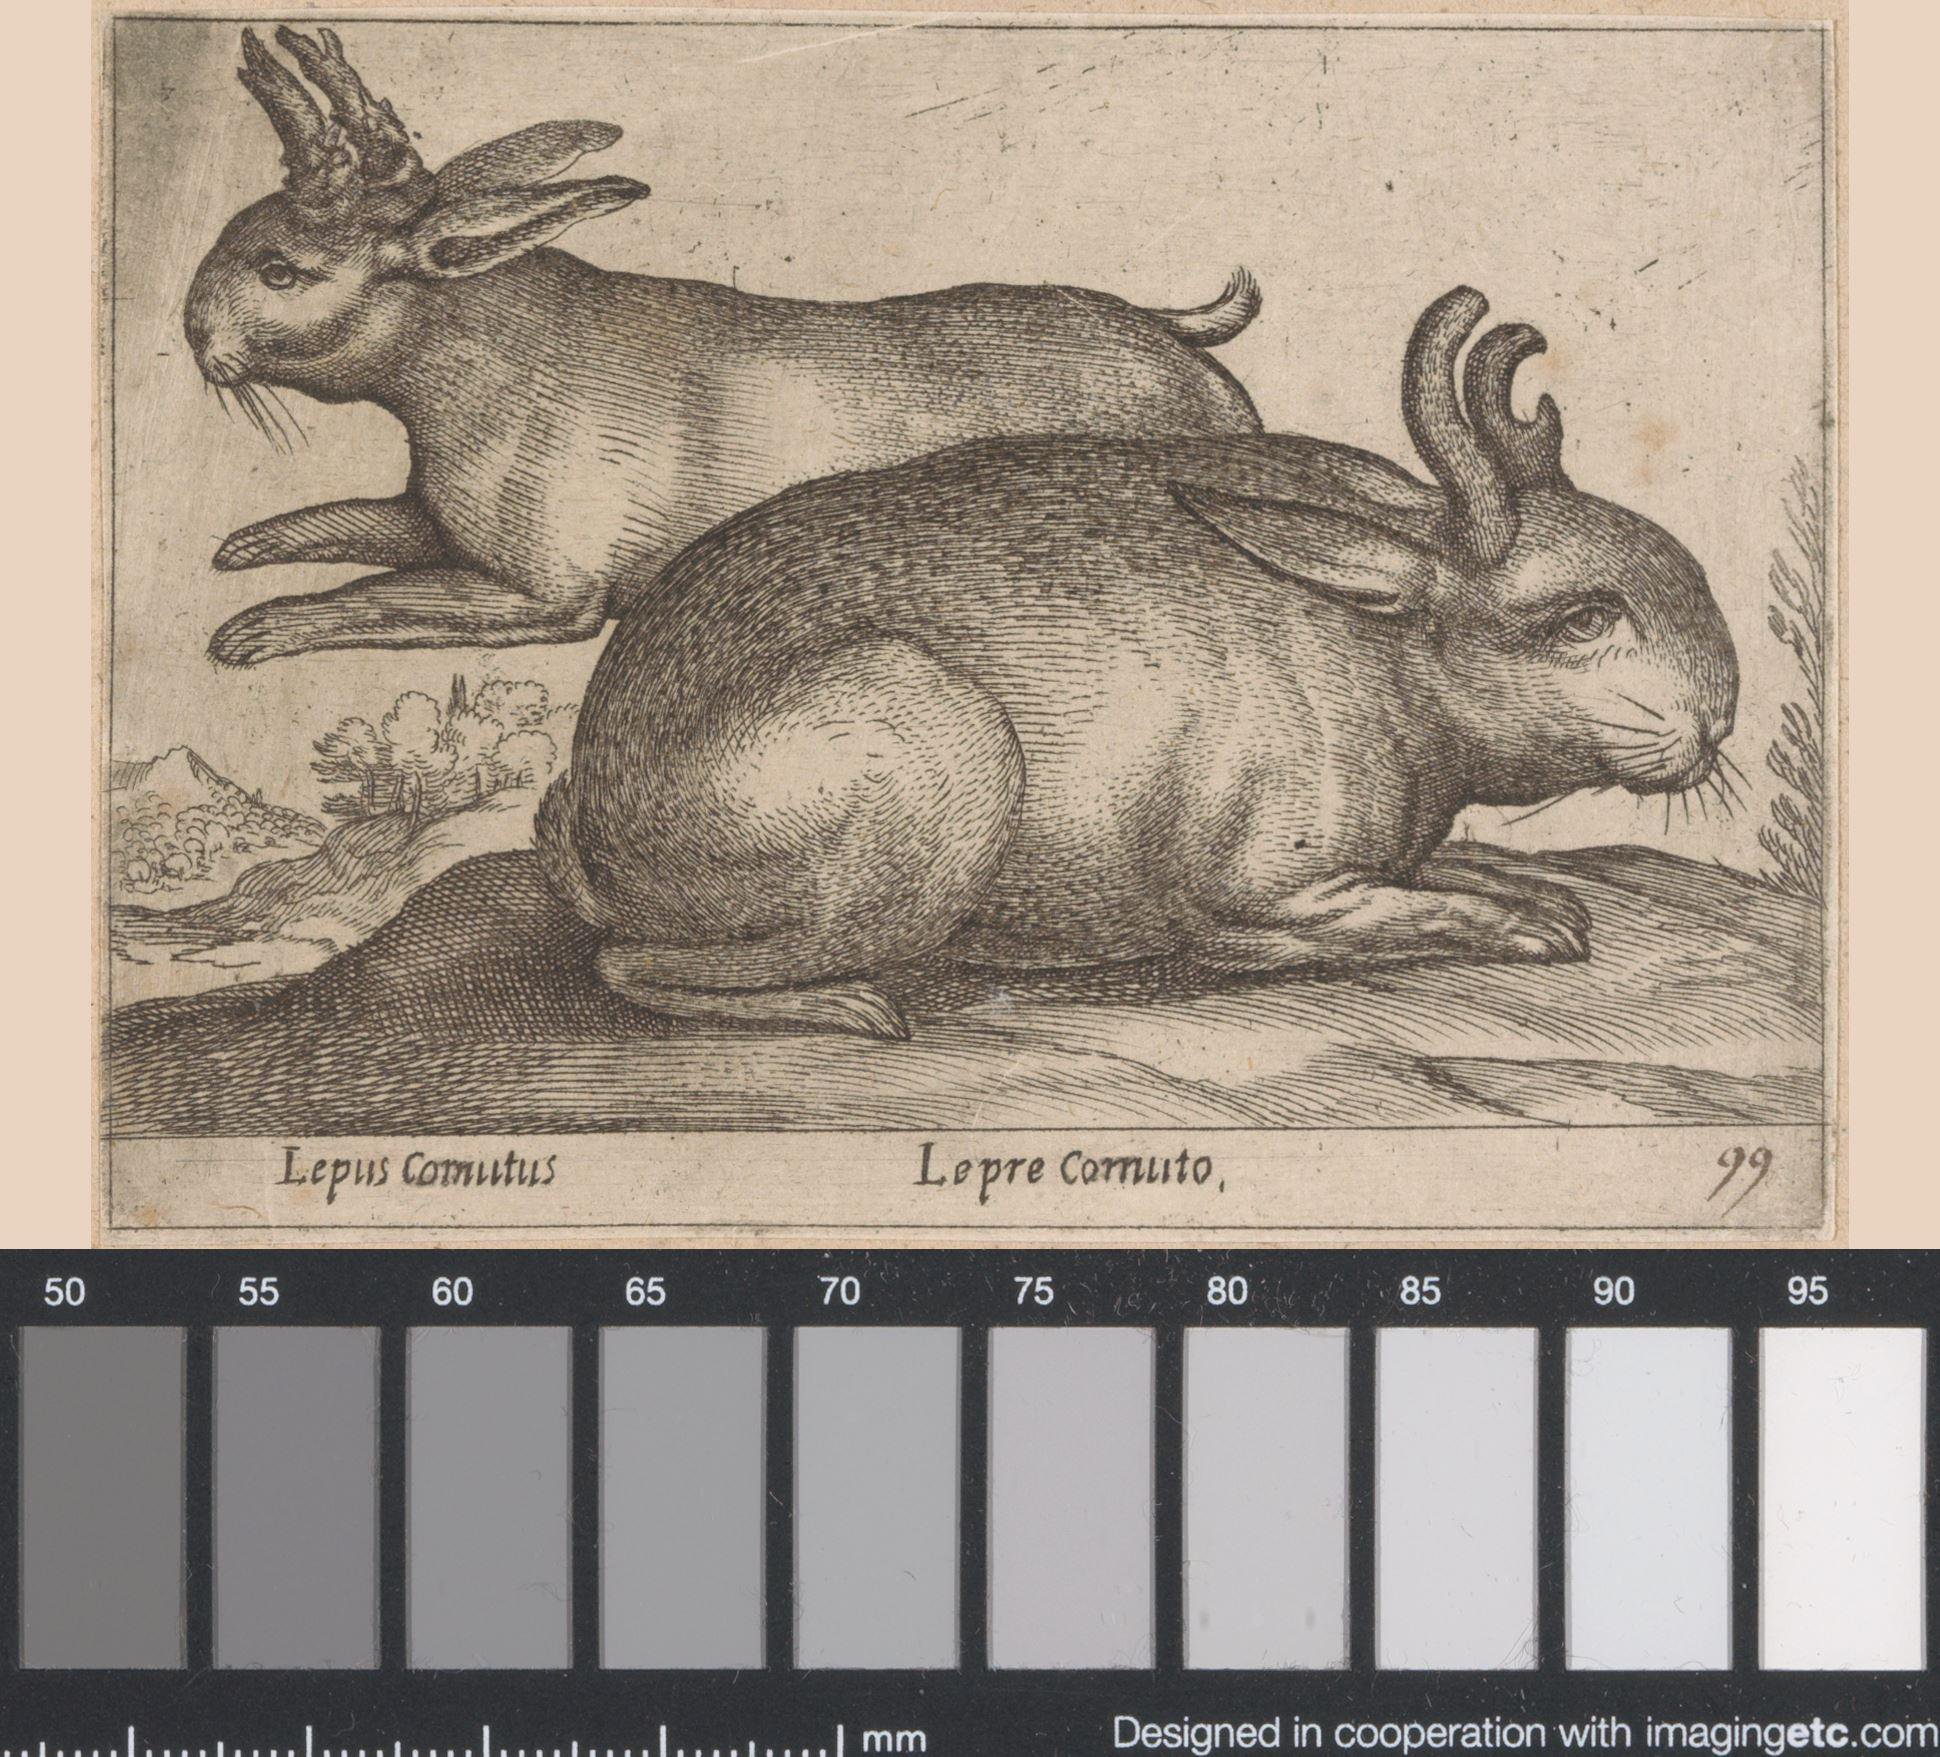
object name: print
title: Dieren en fabelwezens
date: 1565-1630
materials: paper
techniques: etching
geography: rome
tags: mis-shapen animals; monsters, rodents: rabbit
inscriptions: number: ‘99’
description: Deze prent maakt deel uit van een reeks prenten van dieren door Antonio Tempesta. Bekend is dat een tweede staat (met nummering) van deze serie is uitgegeven door Giovanni Giacomo de' Rossi in 1650. Onbekend is wie de eerste staat heeft uitgegeven en wanneer.